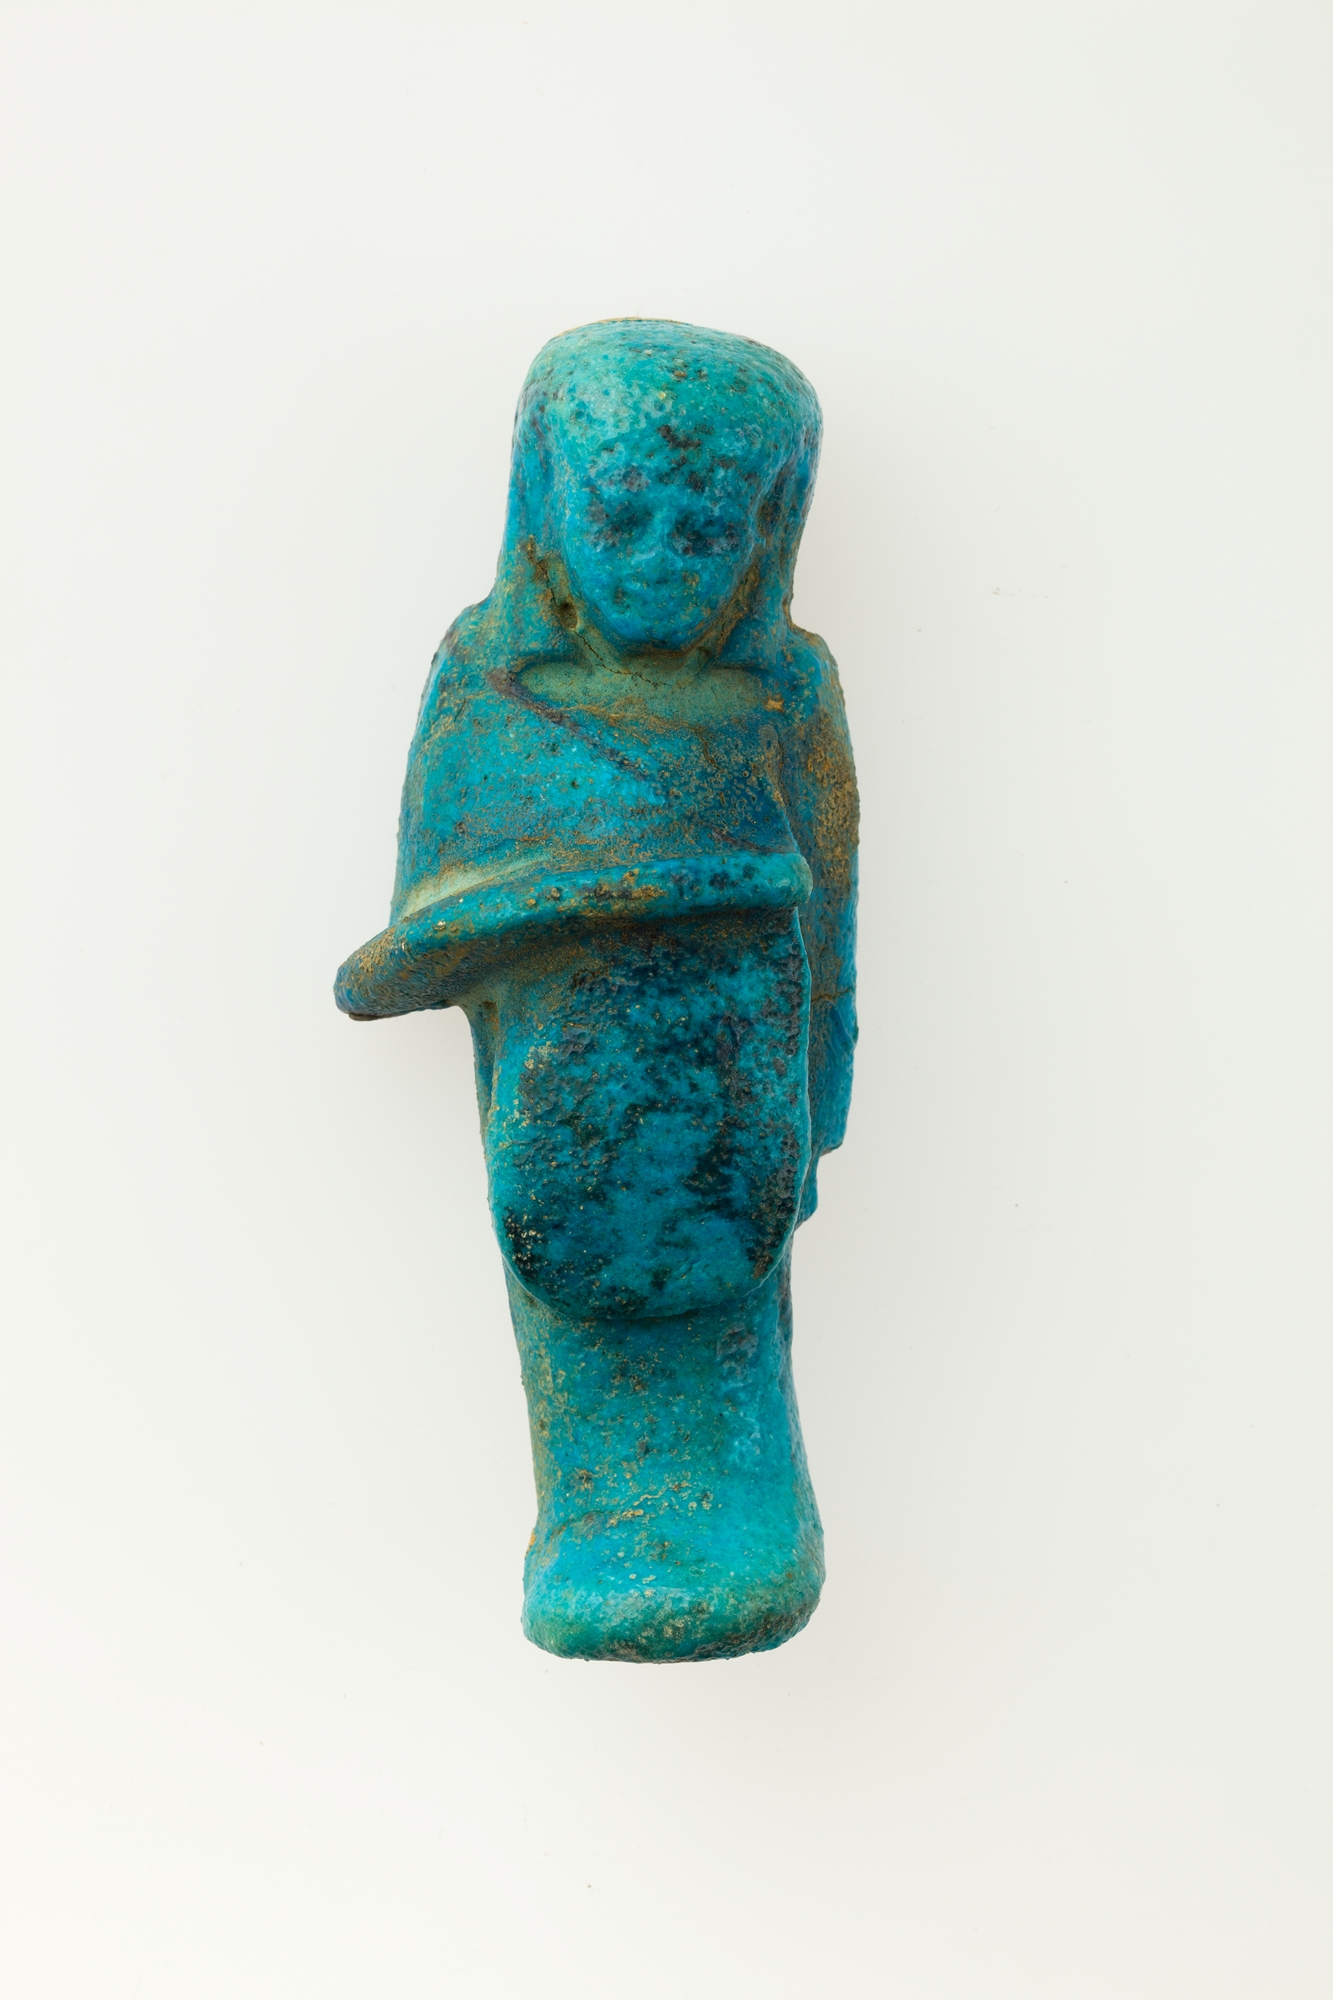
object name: shabti, henettawy c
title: Overseer Shabti of Henettawy (C), Daughter of Isetemkheb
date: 990-970 BCE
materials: faience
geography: egypt